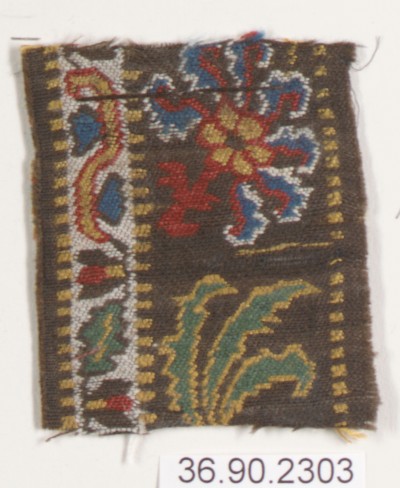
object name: border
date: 1801-1900